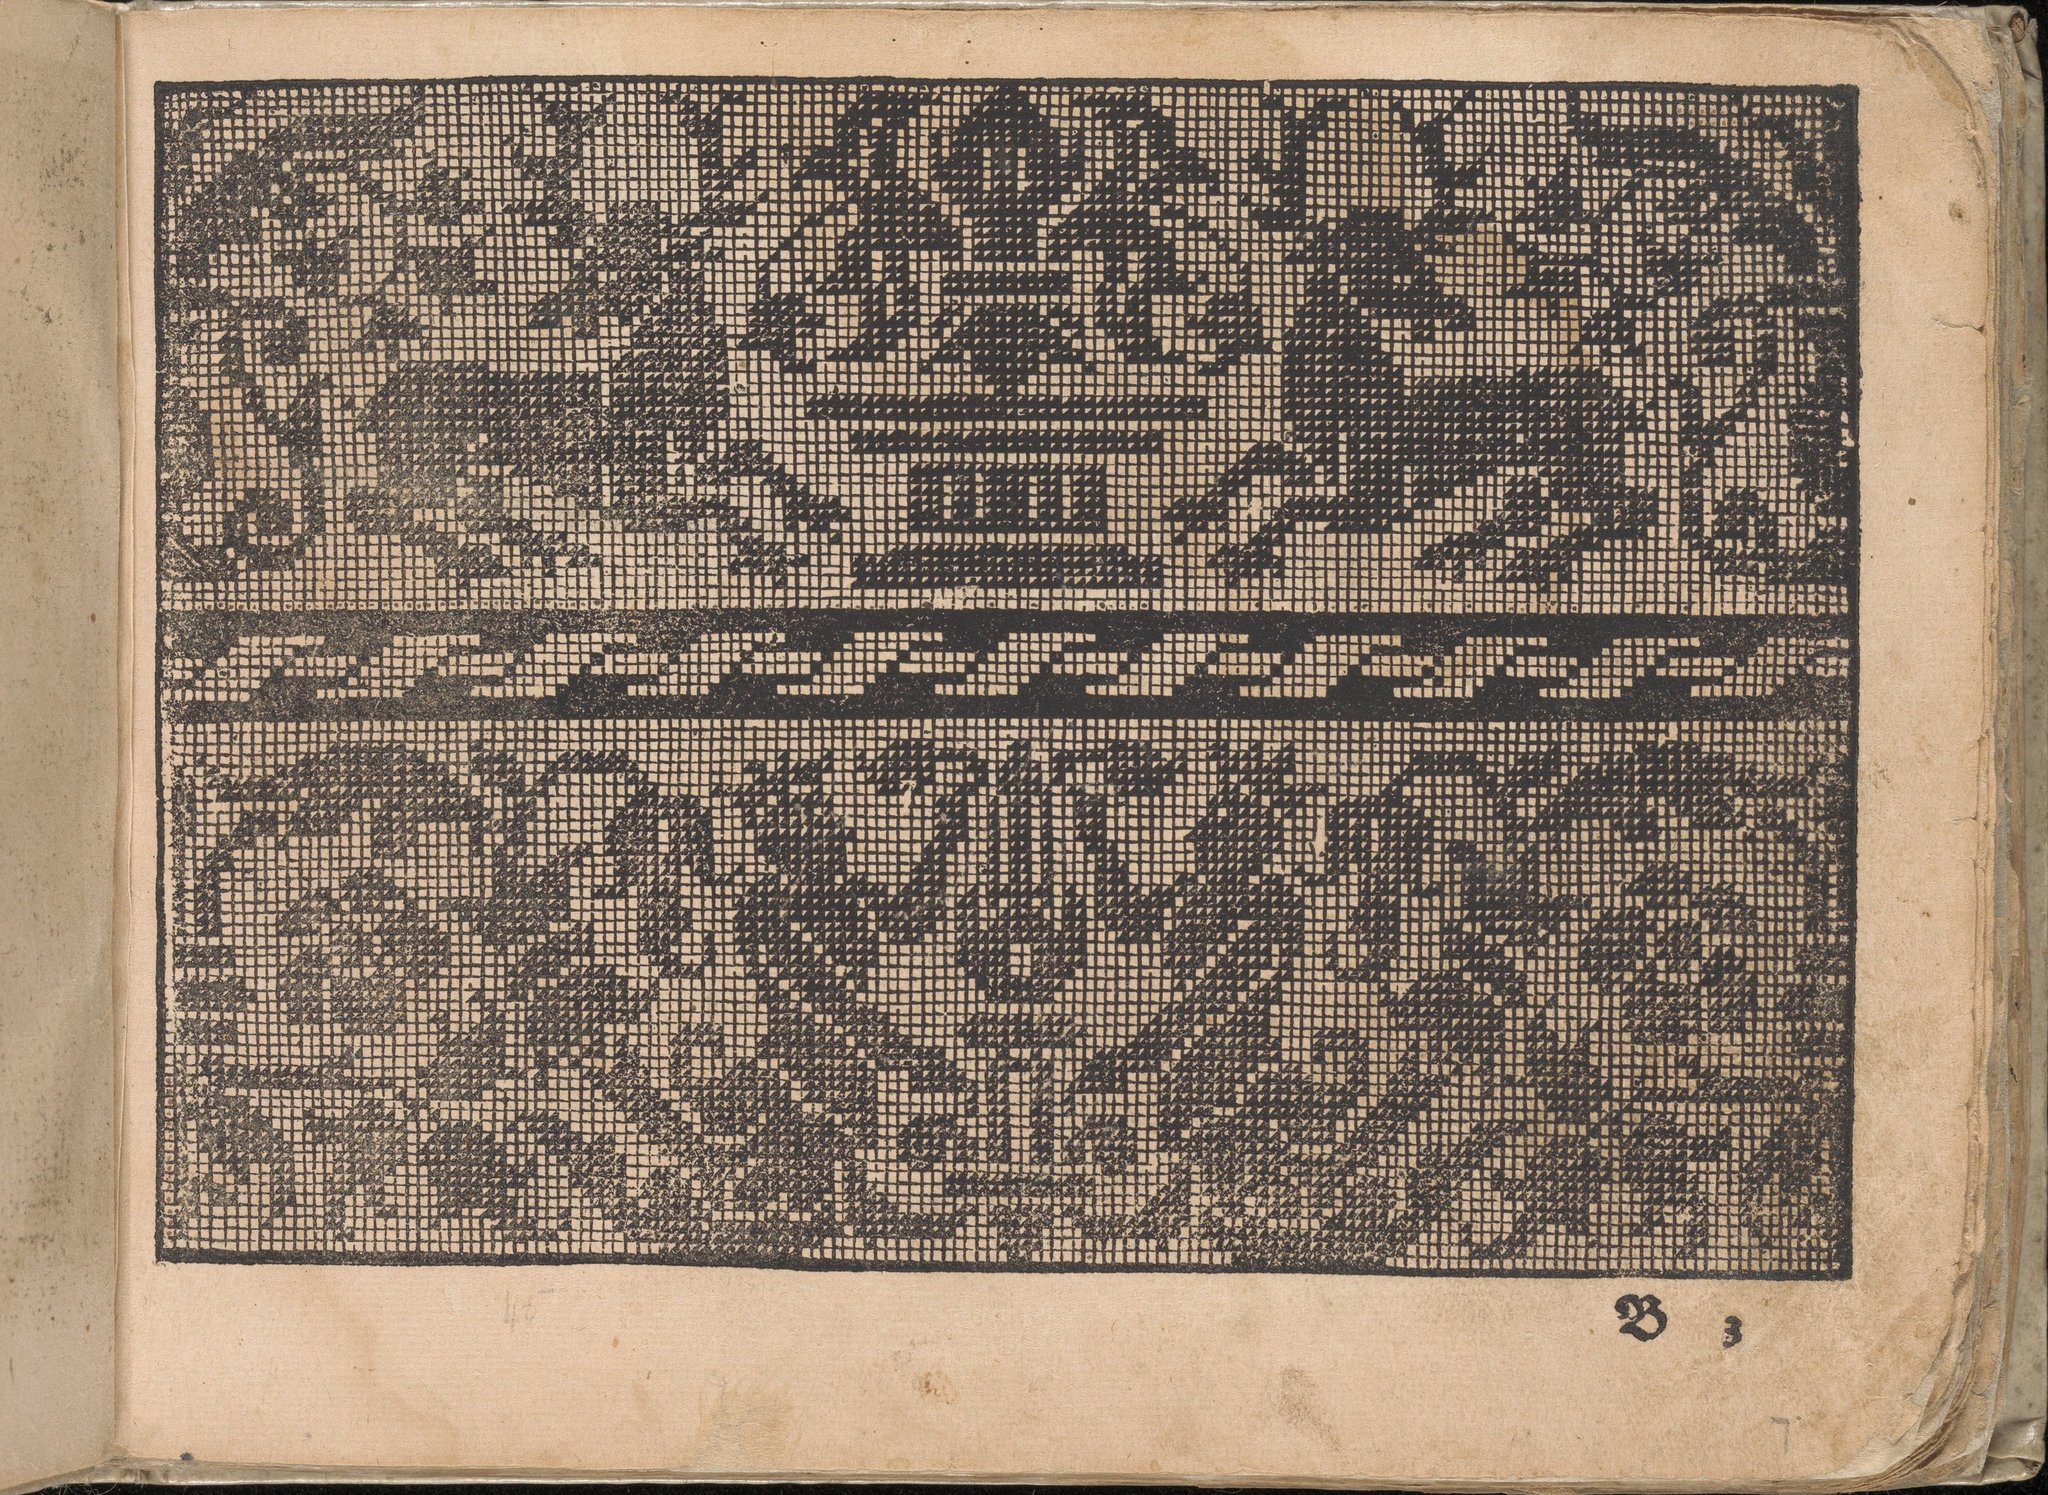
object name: book print ornament architecture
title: Neu künstlich Modelbuch (page 7r)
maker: bernhard jobin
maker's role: publisher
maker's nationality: swiss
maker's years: 1535-1597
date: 1598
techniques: woodcut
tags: human figures,animals,flowers